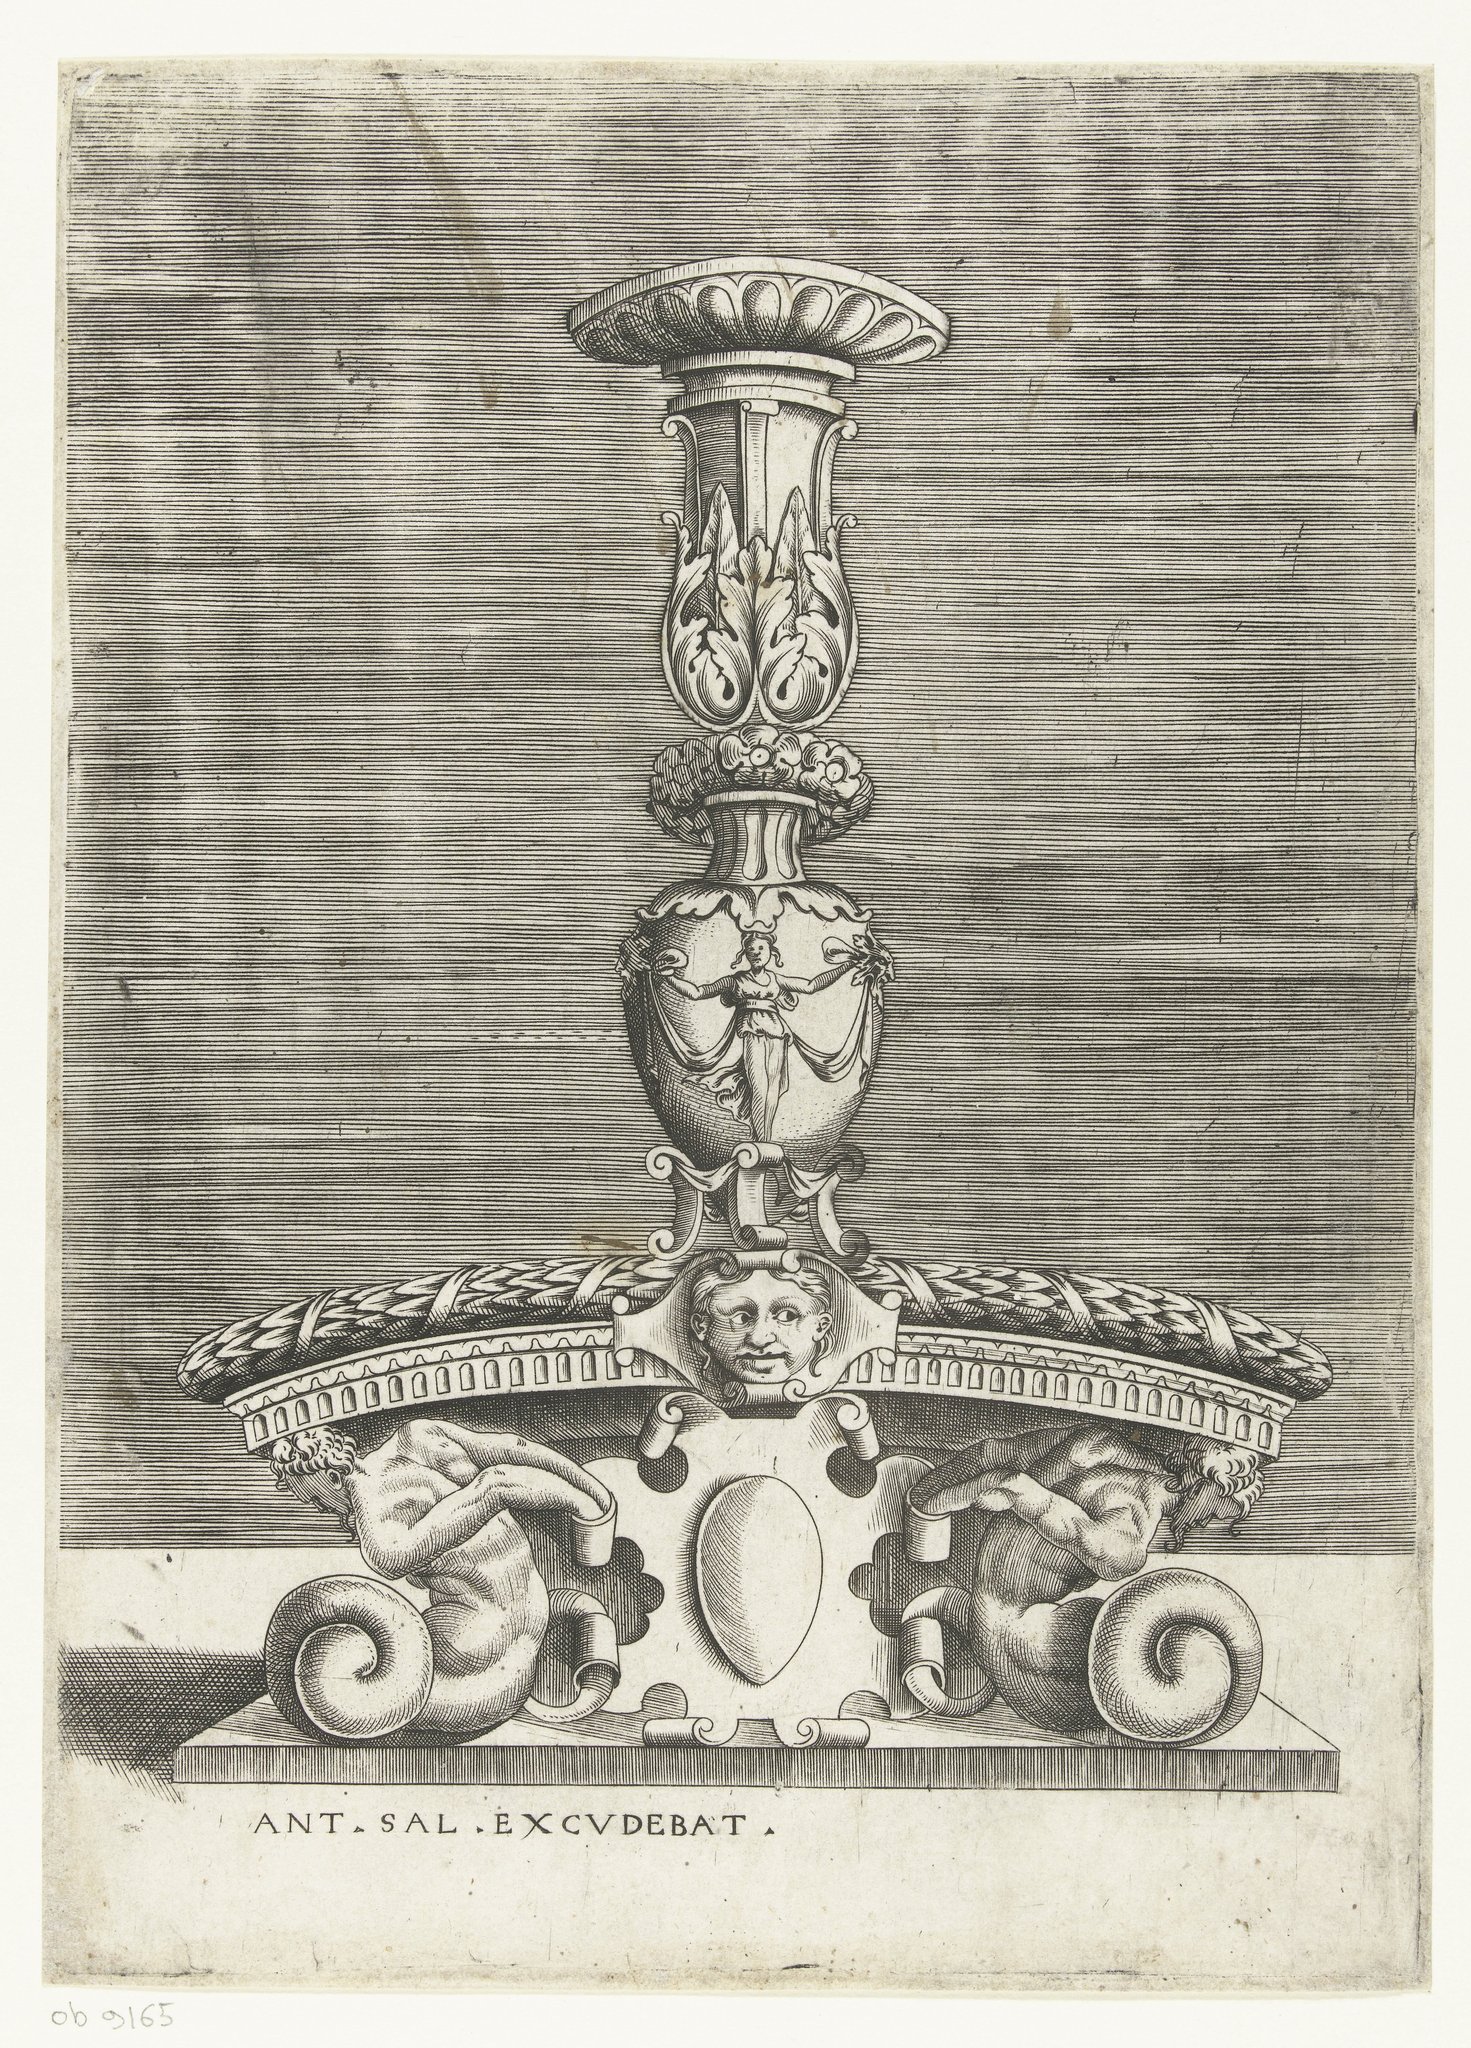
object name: ornament print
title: Kandelaars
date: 1552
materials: paper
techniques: engraving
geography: italy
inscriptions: collector's mark: Lugt 240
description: Kandelaar op een voet, gedecoreerd met een cartouche in een omlijsting van rolwerk tussen twee aan het rolwerk gekentende tritons. Tussen de tritons in hangt een rolwerkcartouche.